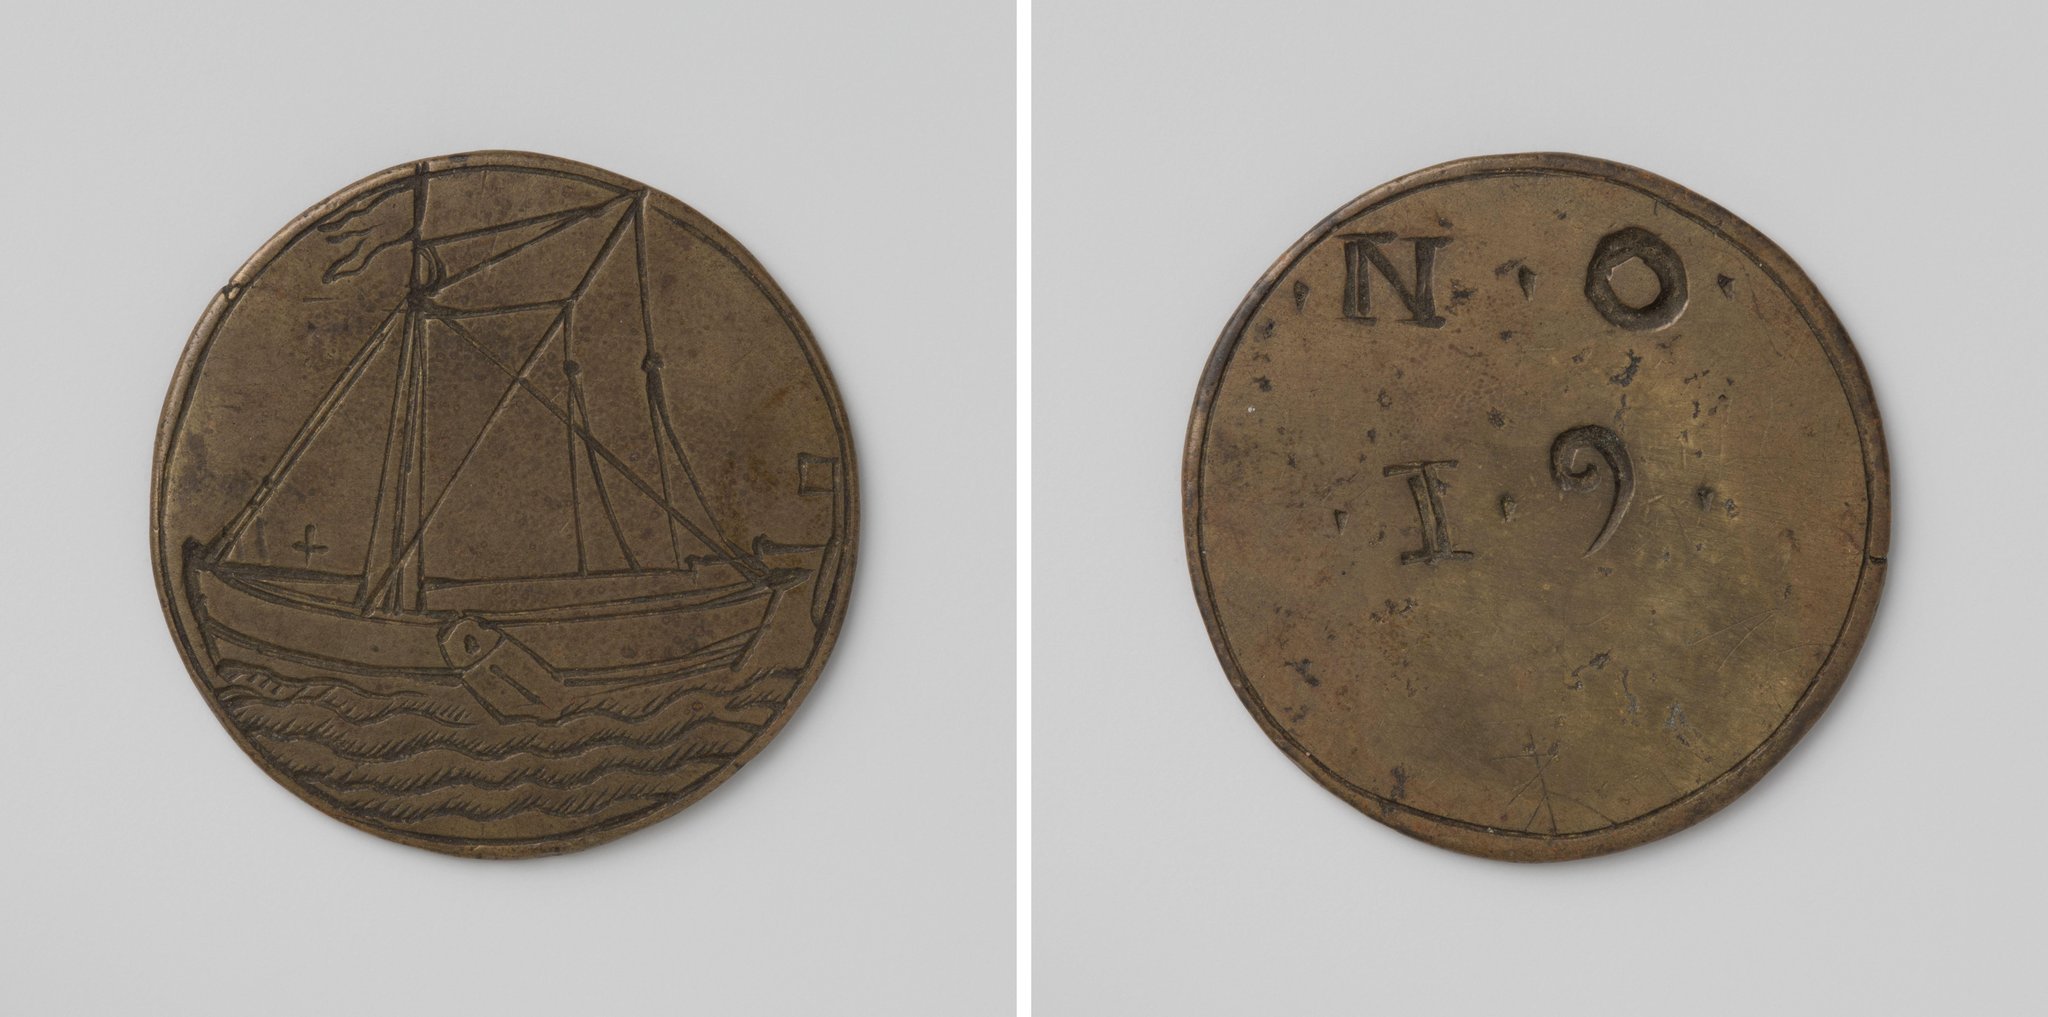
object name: medal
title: Klein schippersgilde van Rotterdam, gildepenning met no. 19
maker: Anonymous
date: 1600-1700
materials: brass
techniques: engraving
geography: rotterdam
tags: rotterdam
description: Messing penning. Voorzijde: naar links varend zeilschip. Keerzijde: opschrift: N.O. 1.9